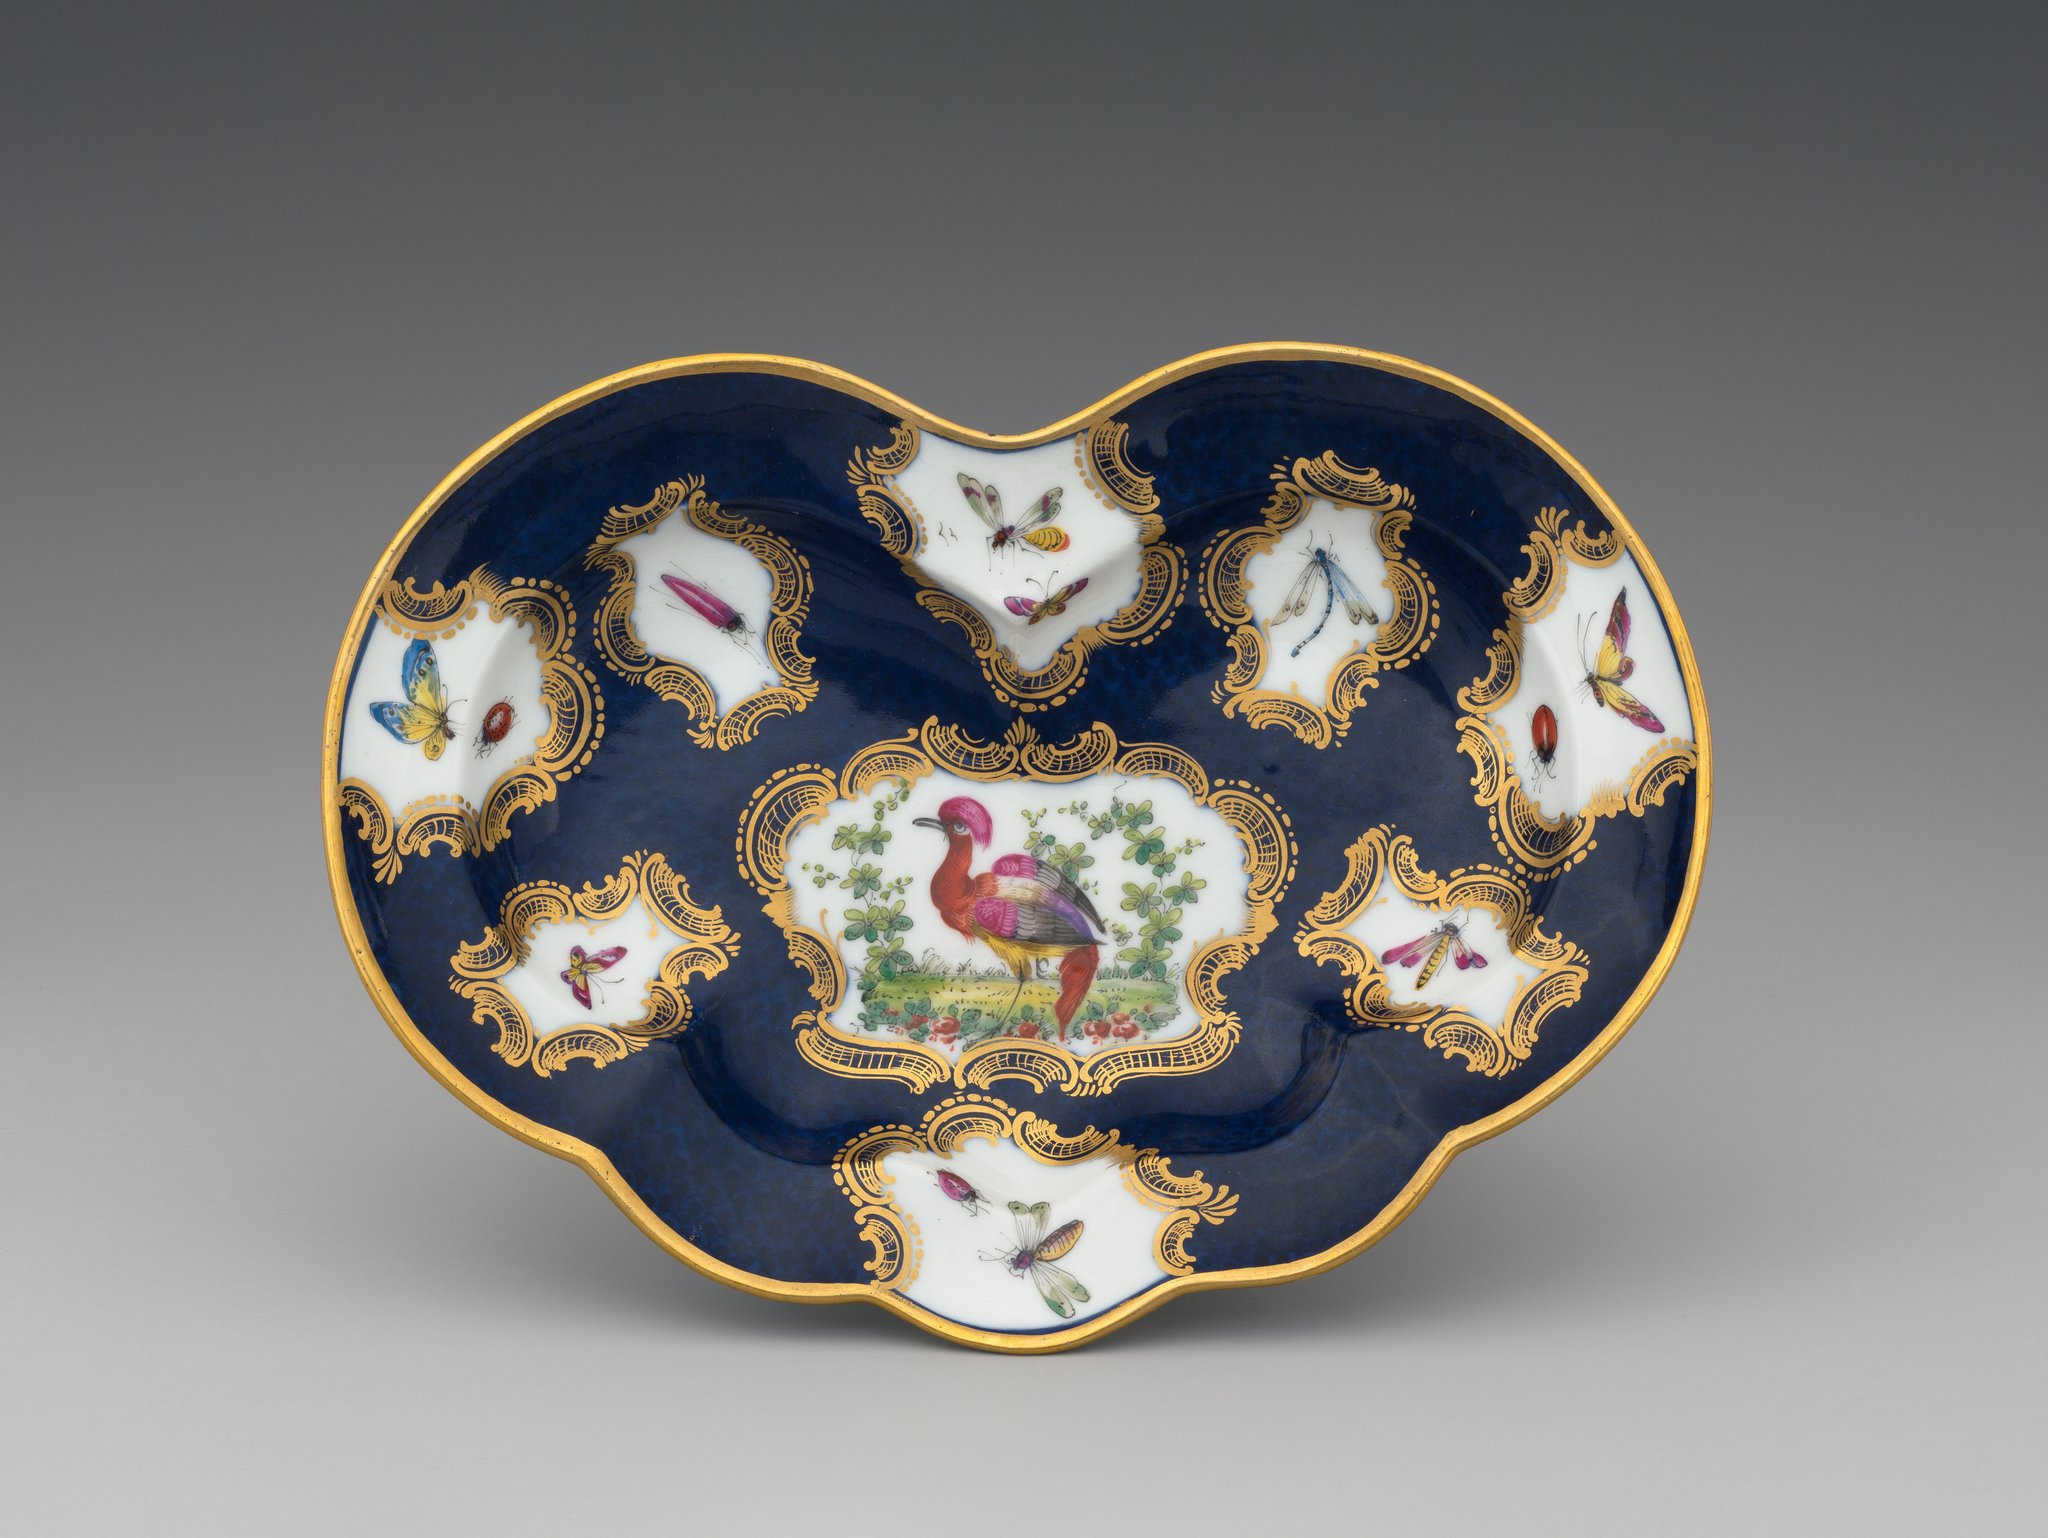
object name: dish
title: Heart-shaped dish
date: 1801-1900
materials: soft paste porcelain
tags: birds,insects,bees,butterflies